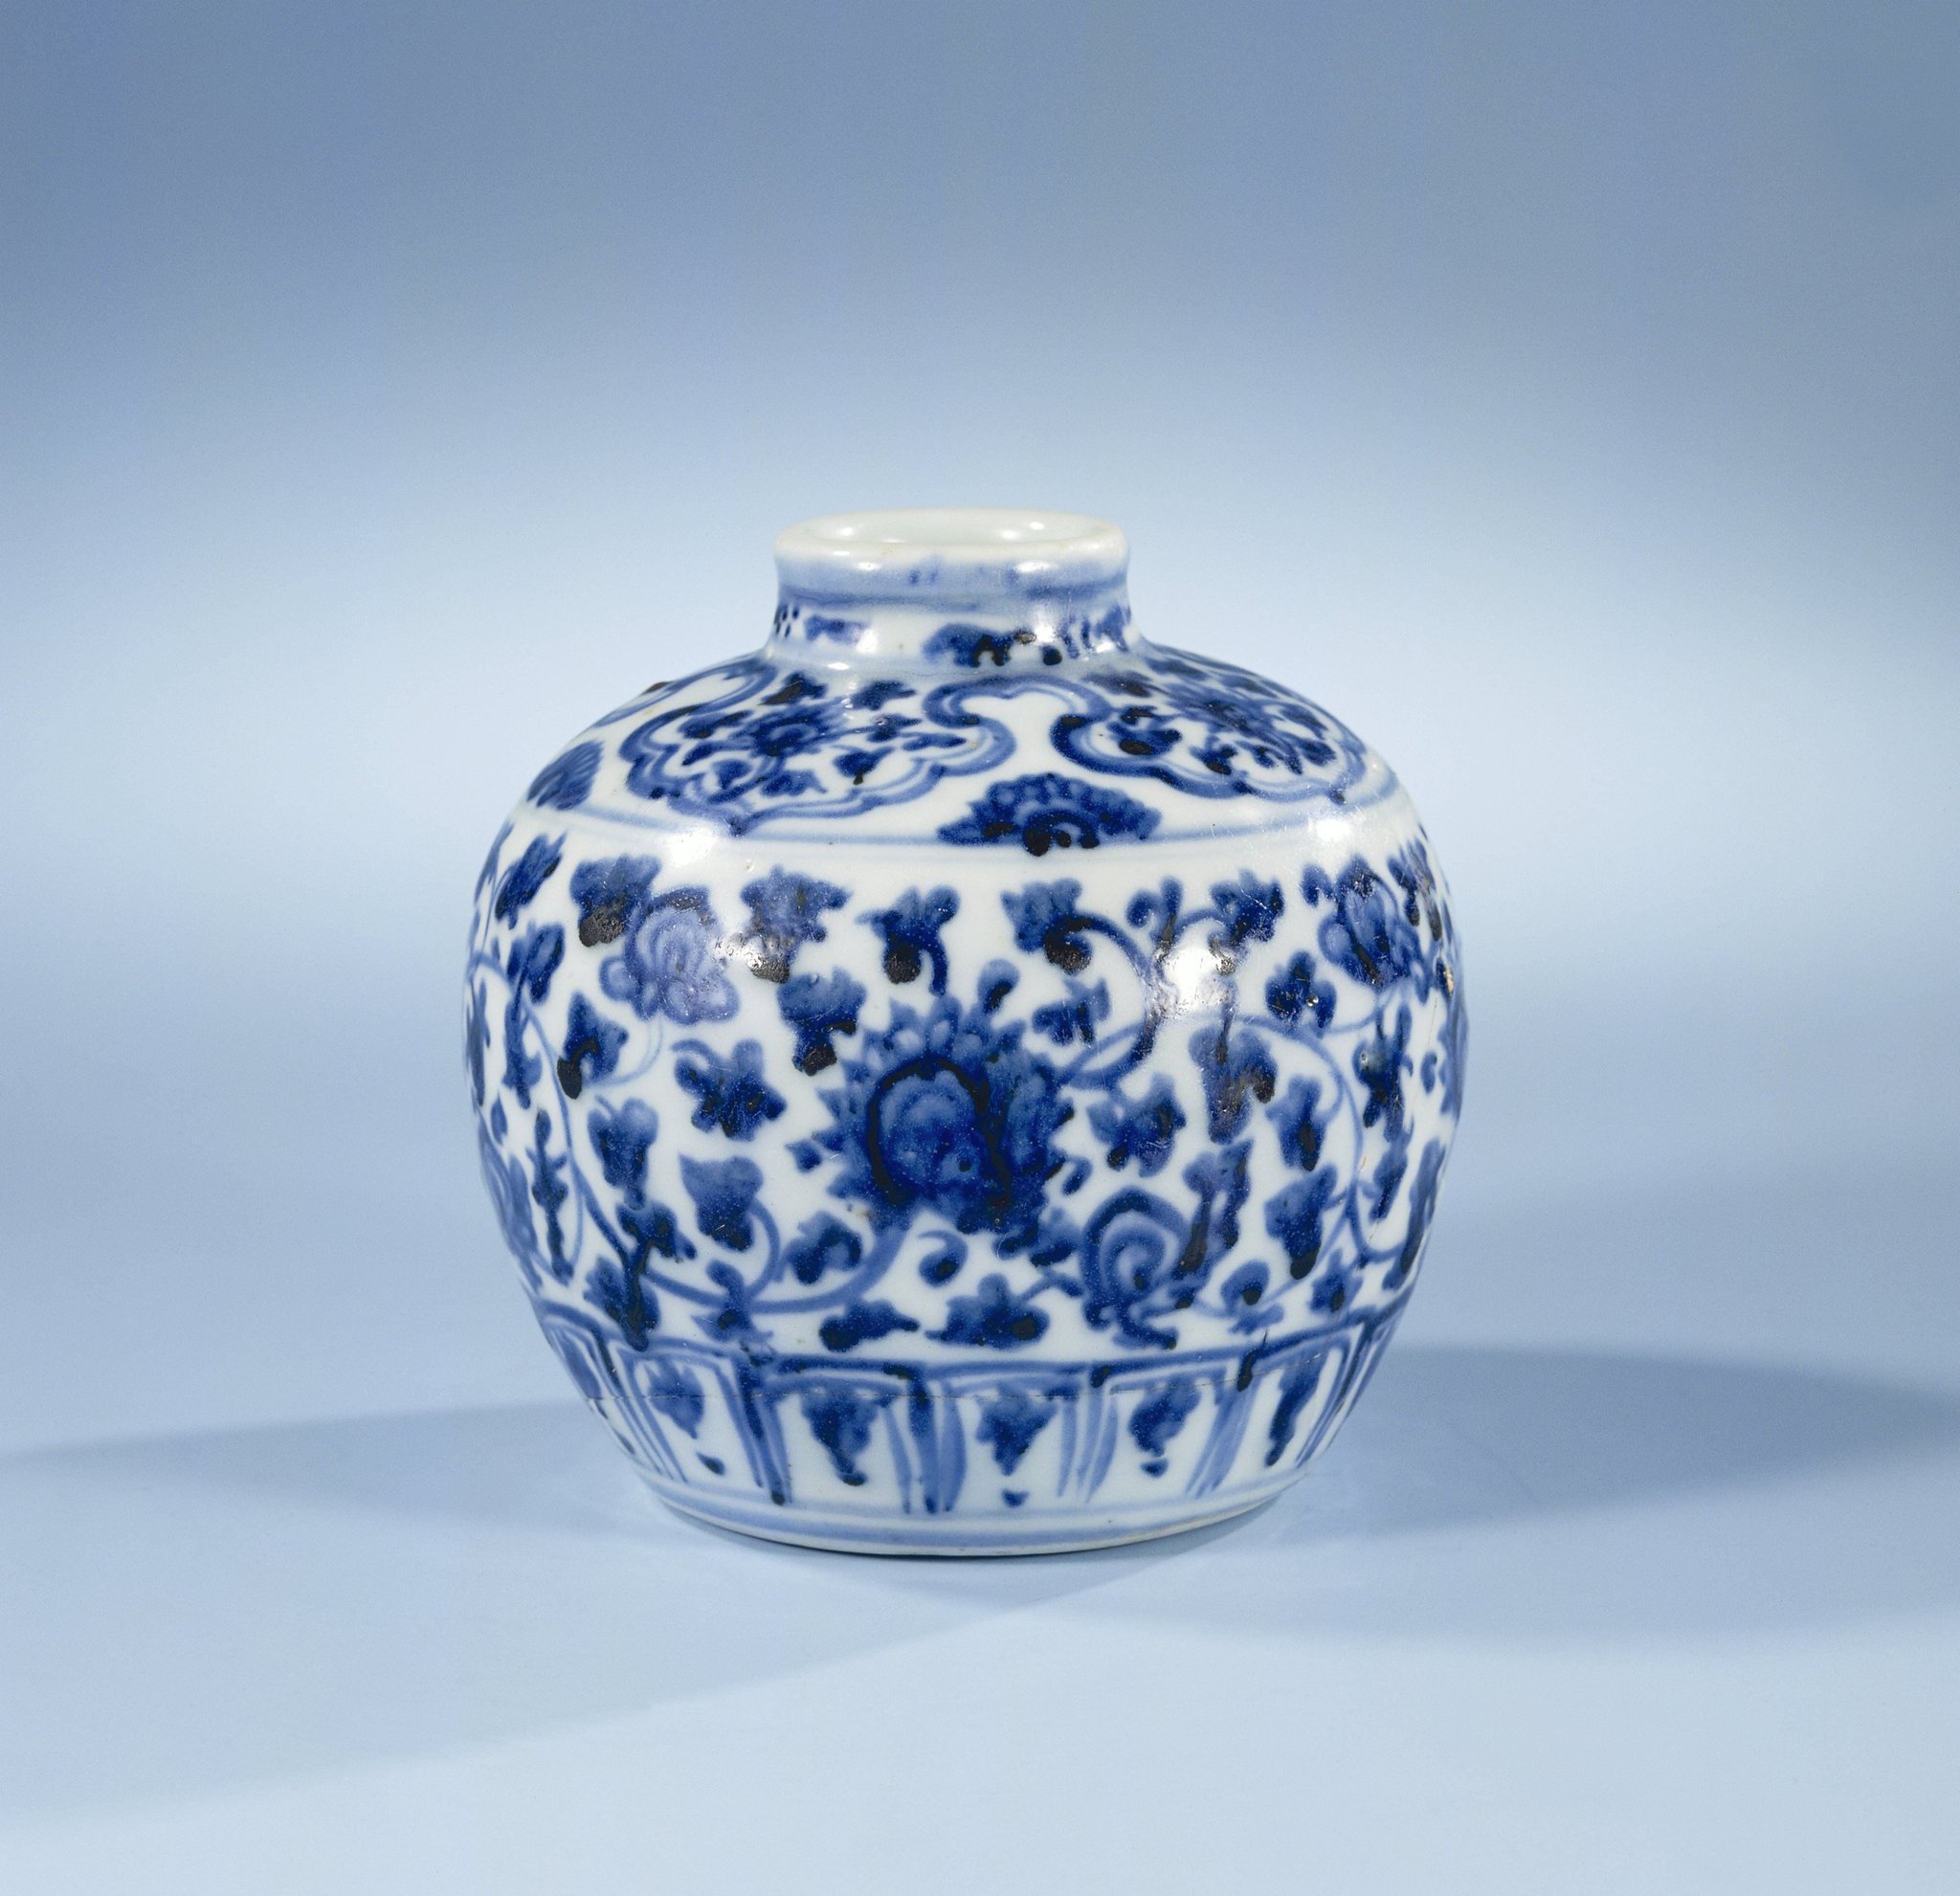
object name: pot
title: Small jar with a continuous flower spray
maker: Anonymous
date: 1475-1499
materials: cobalt, glaze, paint, porcelain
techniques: firing, turning, vitrification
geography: china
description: Kleine pot op lage voetring met een vlakke, ongeglazuurde witte bodem met enkele ijzerbruine vlekken. De pot heeft een bolvormig lichaam en een korte hals met kleine opening. Gedecoreerd in onderglazuur blauw met rondom het lichaam doorlopende bloemranken. Rondom de voet een rand van gestileerde lotusbladeren. De schouder van de pot wordt gesierd door een met lotusbloemen gevuld wolkenmotief.